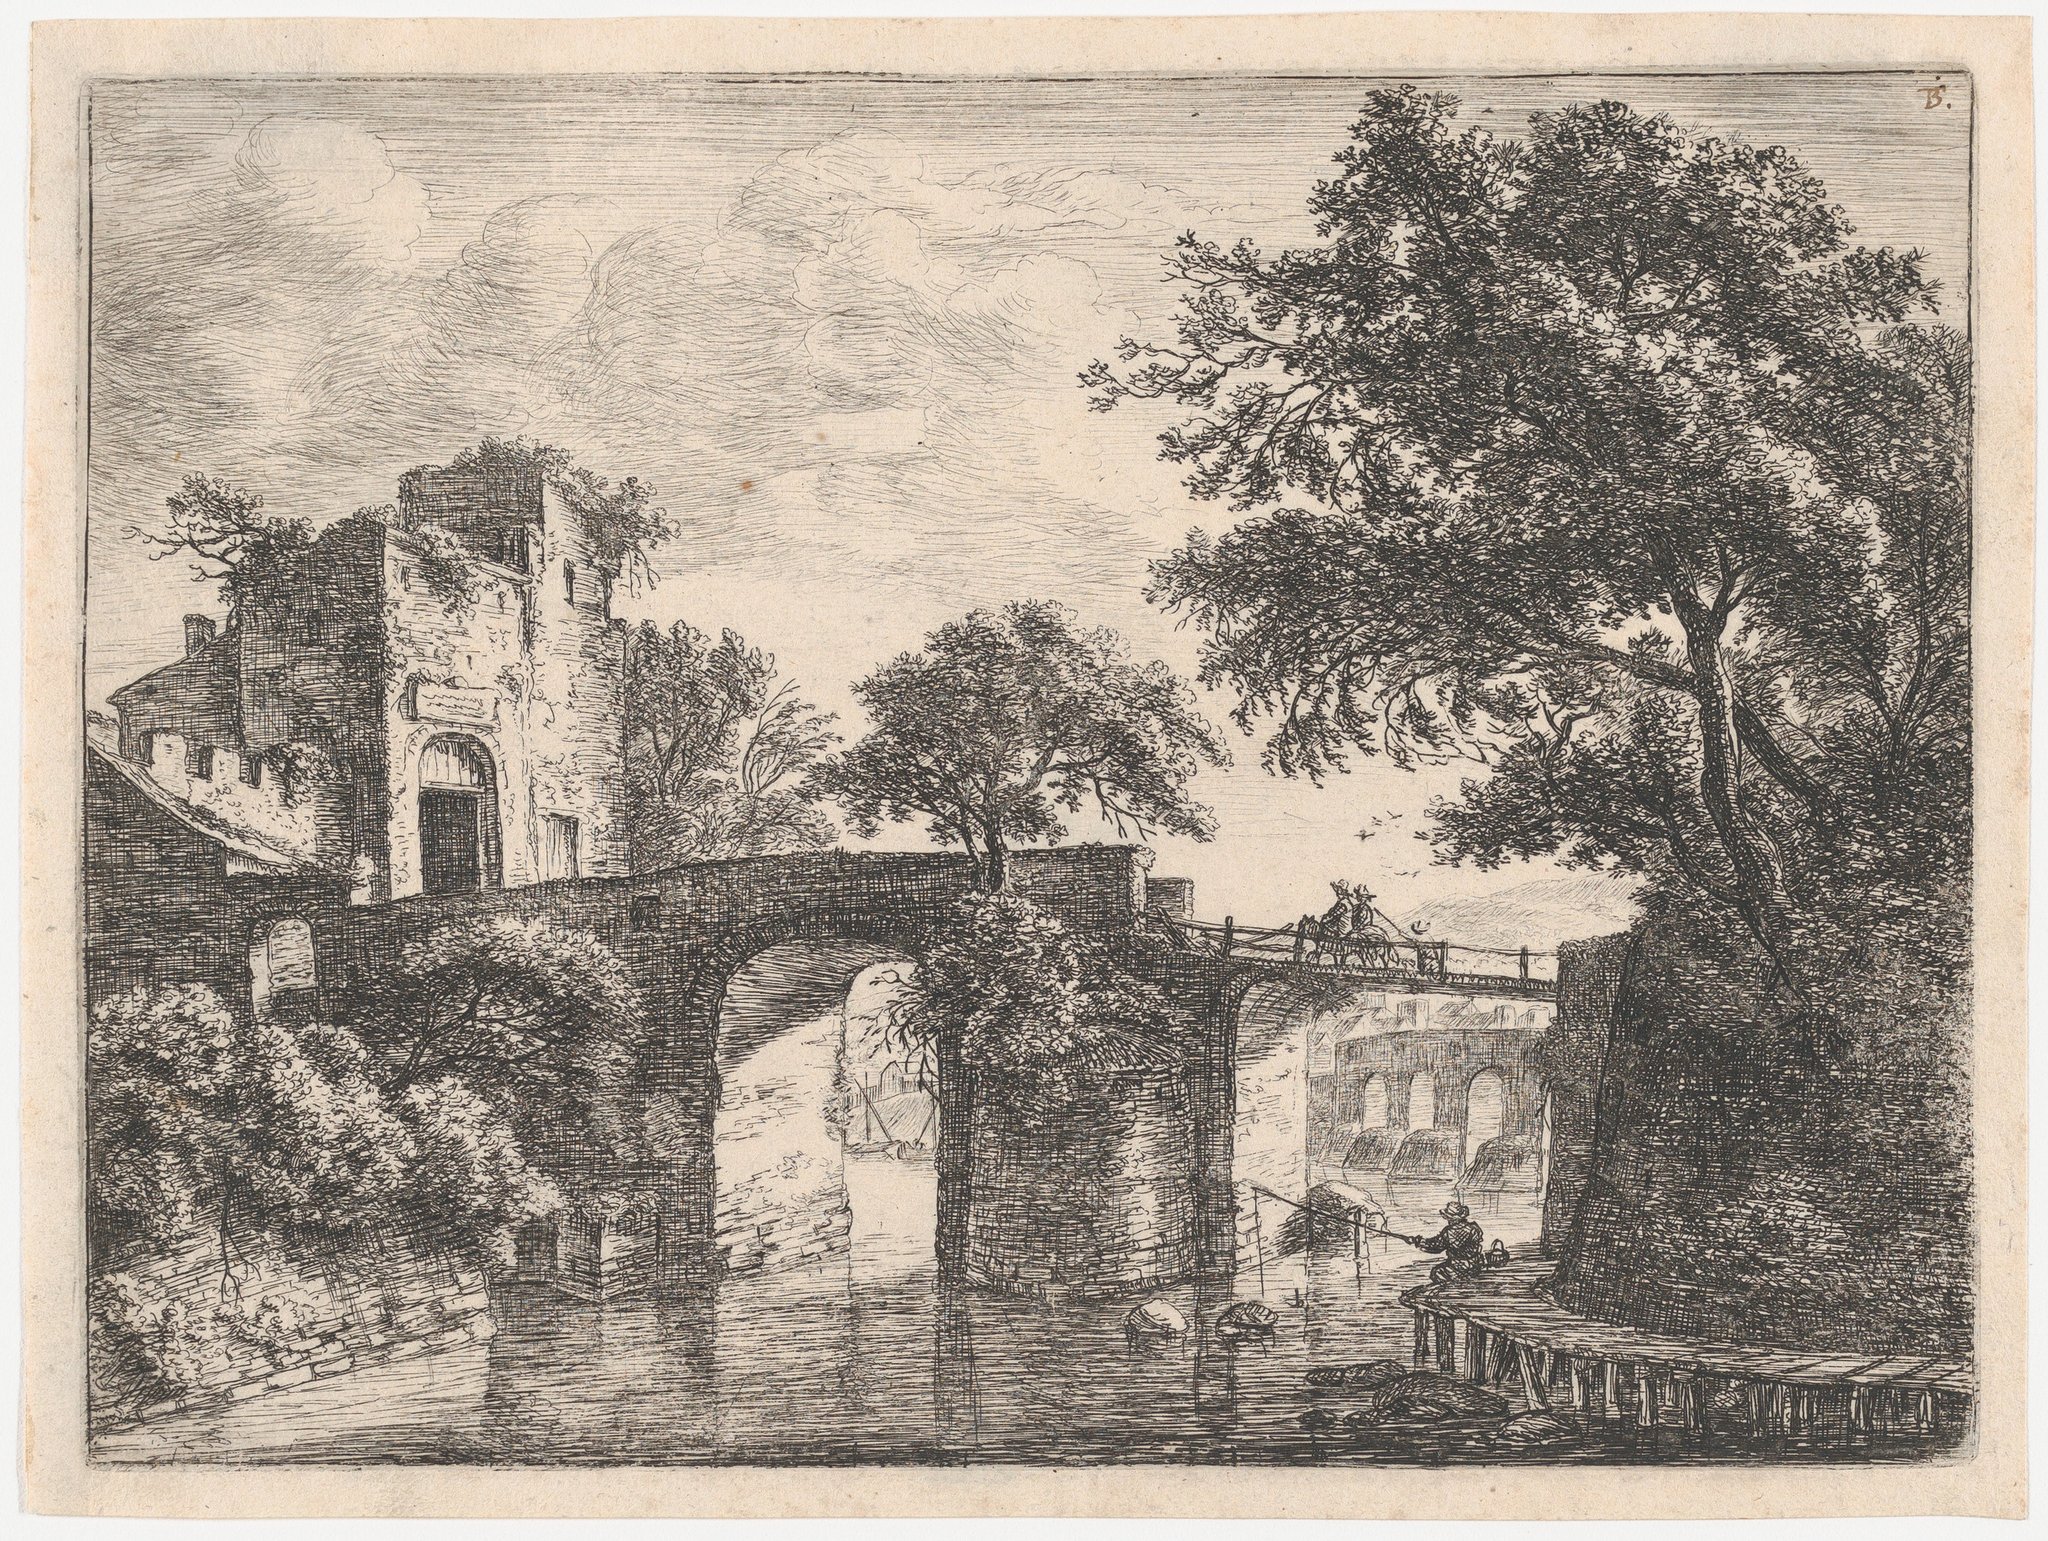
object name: print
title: Two Stone Bridges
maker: anthonie waterloo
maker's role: artist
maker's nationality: dutch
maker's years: 1609-1690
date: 1601-1700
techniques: etching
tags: bridges,fishing